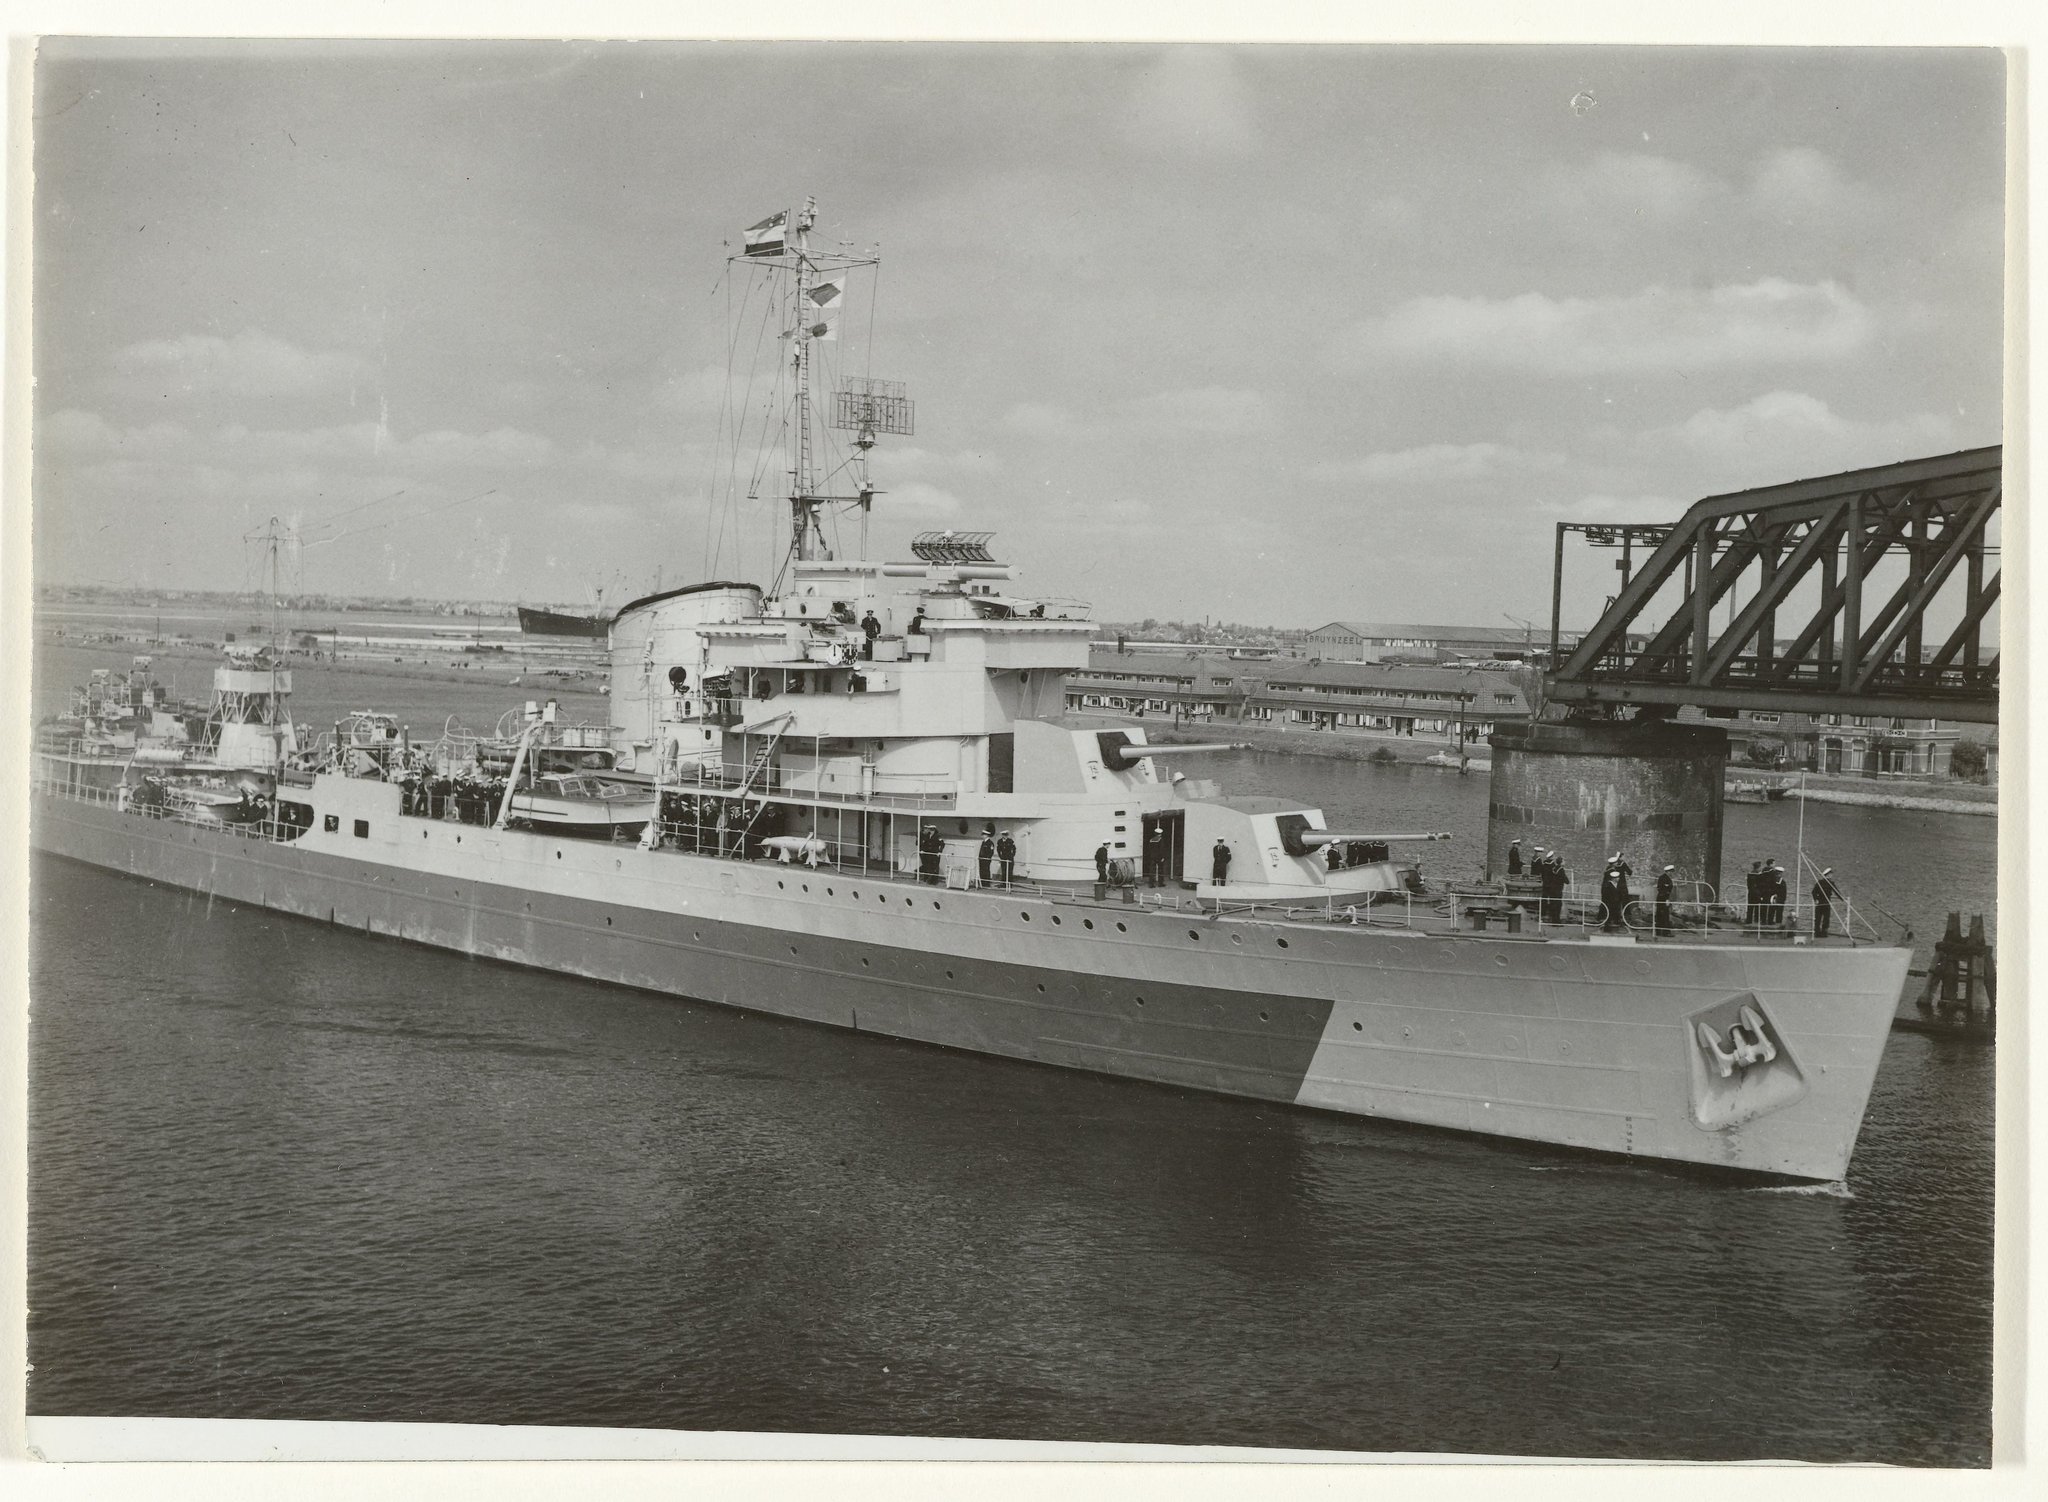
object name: photograph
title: Terugkeer van H. M. "Tromp" te Amsterdam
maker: koos raucamp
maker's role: fotograaf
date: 1945-1946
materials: photographic support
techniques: photography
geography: amsterdam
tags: amsterdam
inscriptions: stamp: ‘COPYRIGHT / 'ANEFO' / ALGEMEEN NEDERLANDSCH FOTOBUREAU’, inscription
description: De terugkeer van flotilleleider Hr. Ms. Tromp te Amsterdam. Na zeven jaar vaart de Tromp bij de Hembrug de haven binnen. Het is het enige schip, een kruiser, van de Nederlandse Marine die de slag in de Javazee in februari 1942 overleefde.